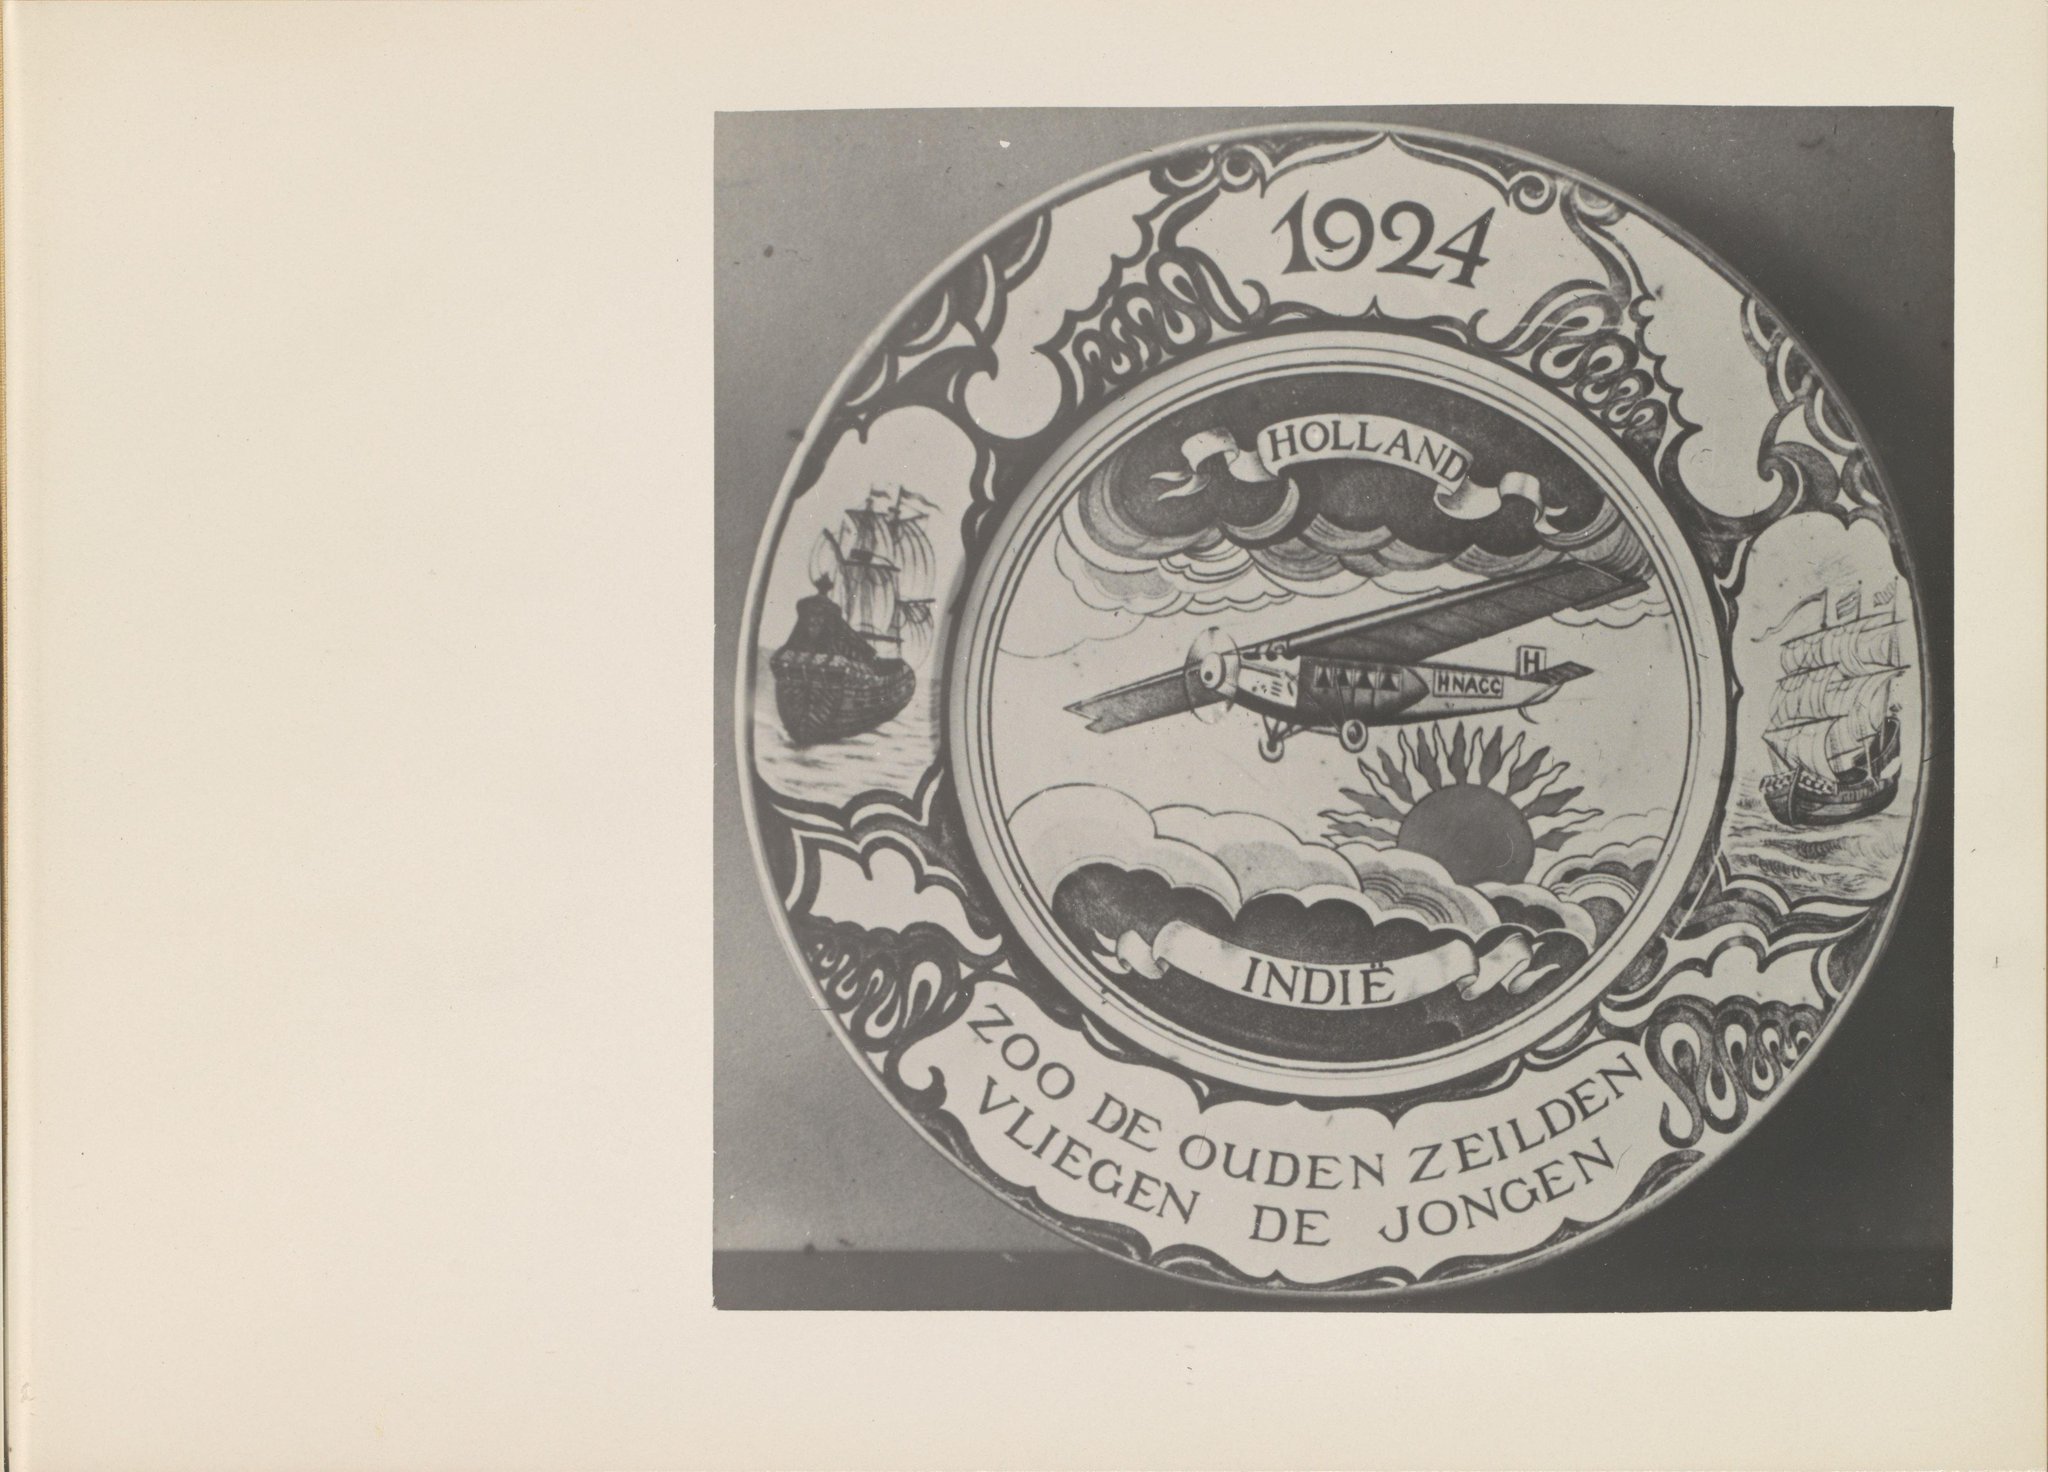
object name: photograph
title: Gedenkbord ter herinnering van de eerste vlucht naar Nederlands-Indië in 1924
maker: Anonymous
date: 1924-1949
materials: cardboard, paper, photographic support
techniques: gelatin silver print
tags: aircraft, aeroplane, airborne traffic, aviation, travelling; tourism, dish, plate, saucer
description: Albumblad met een foto van een herinneringsbord van de eerste vlucht van Nederland naar Nederlands-Indië in 1924, met daarop de tekst "Zoo de ouden zeilden vliegen de jongen". Onderdeel van Herdenkingsalbum van de Indië-lijn van de KLM, deel I.